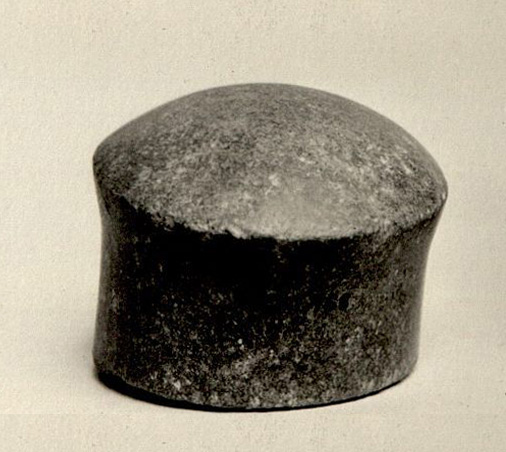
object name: pestle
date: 1981-1640 BCE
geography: egypt